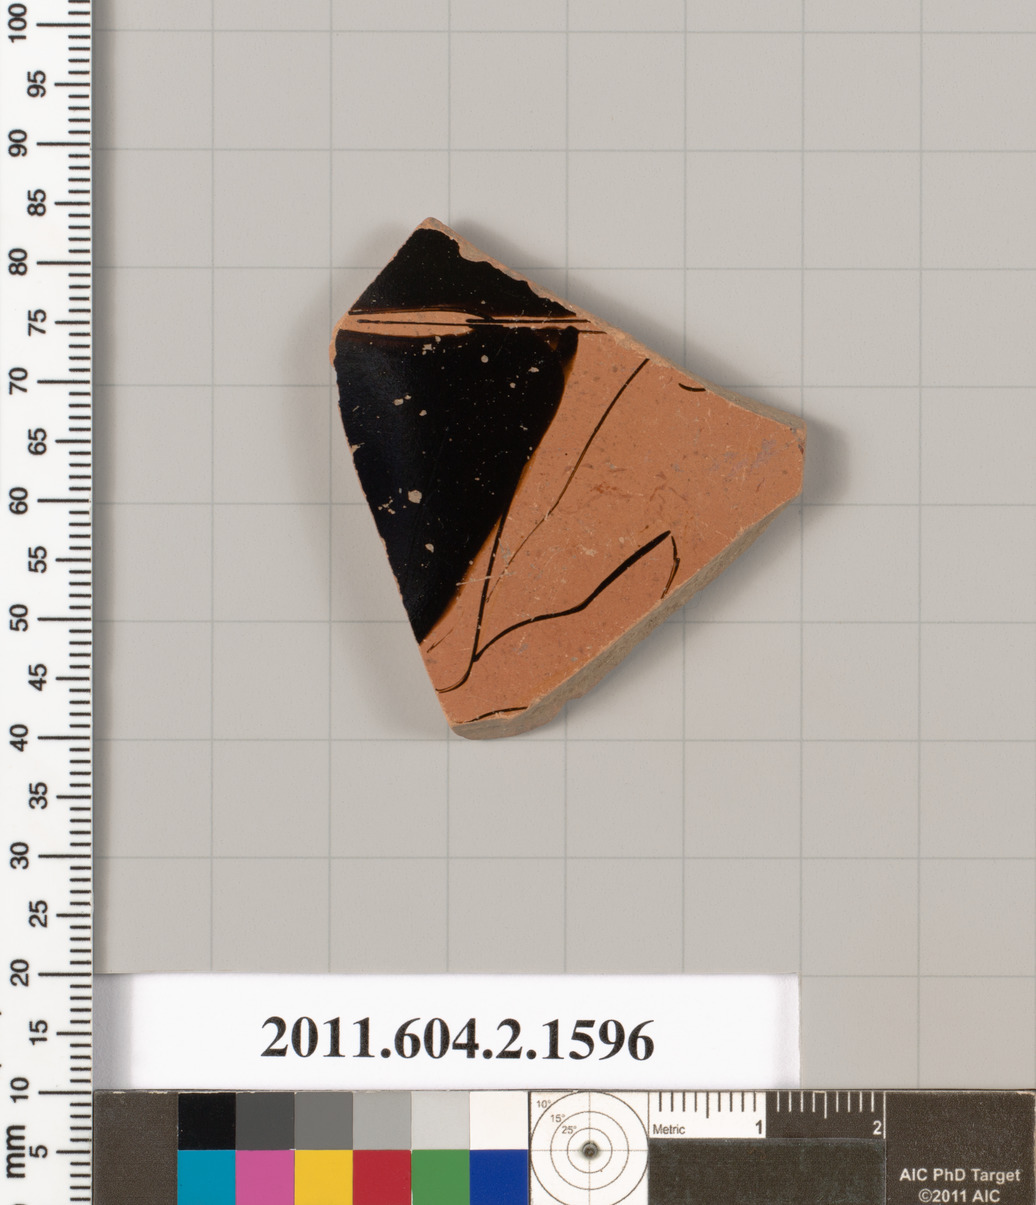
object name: skyphos fragment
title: Terracotta fragment of a skyphos (deep drinking cup)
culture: greek, attic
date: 460-440 BCE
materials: terracotta